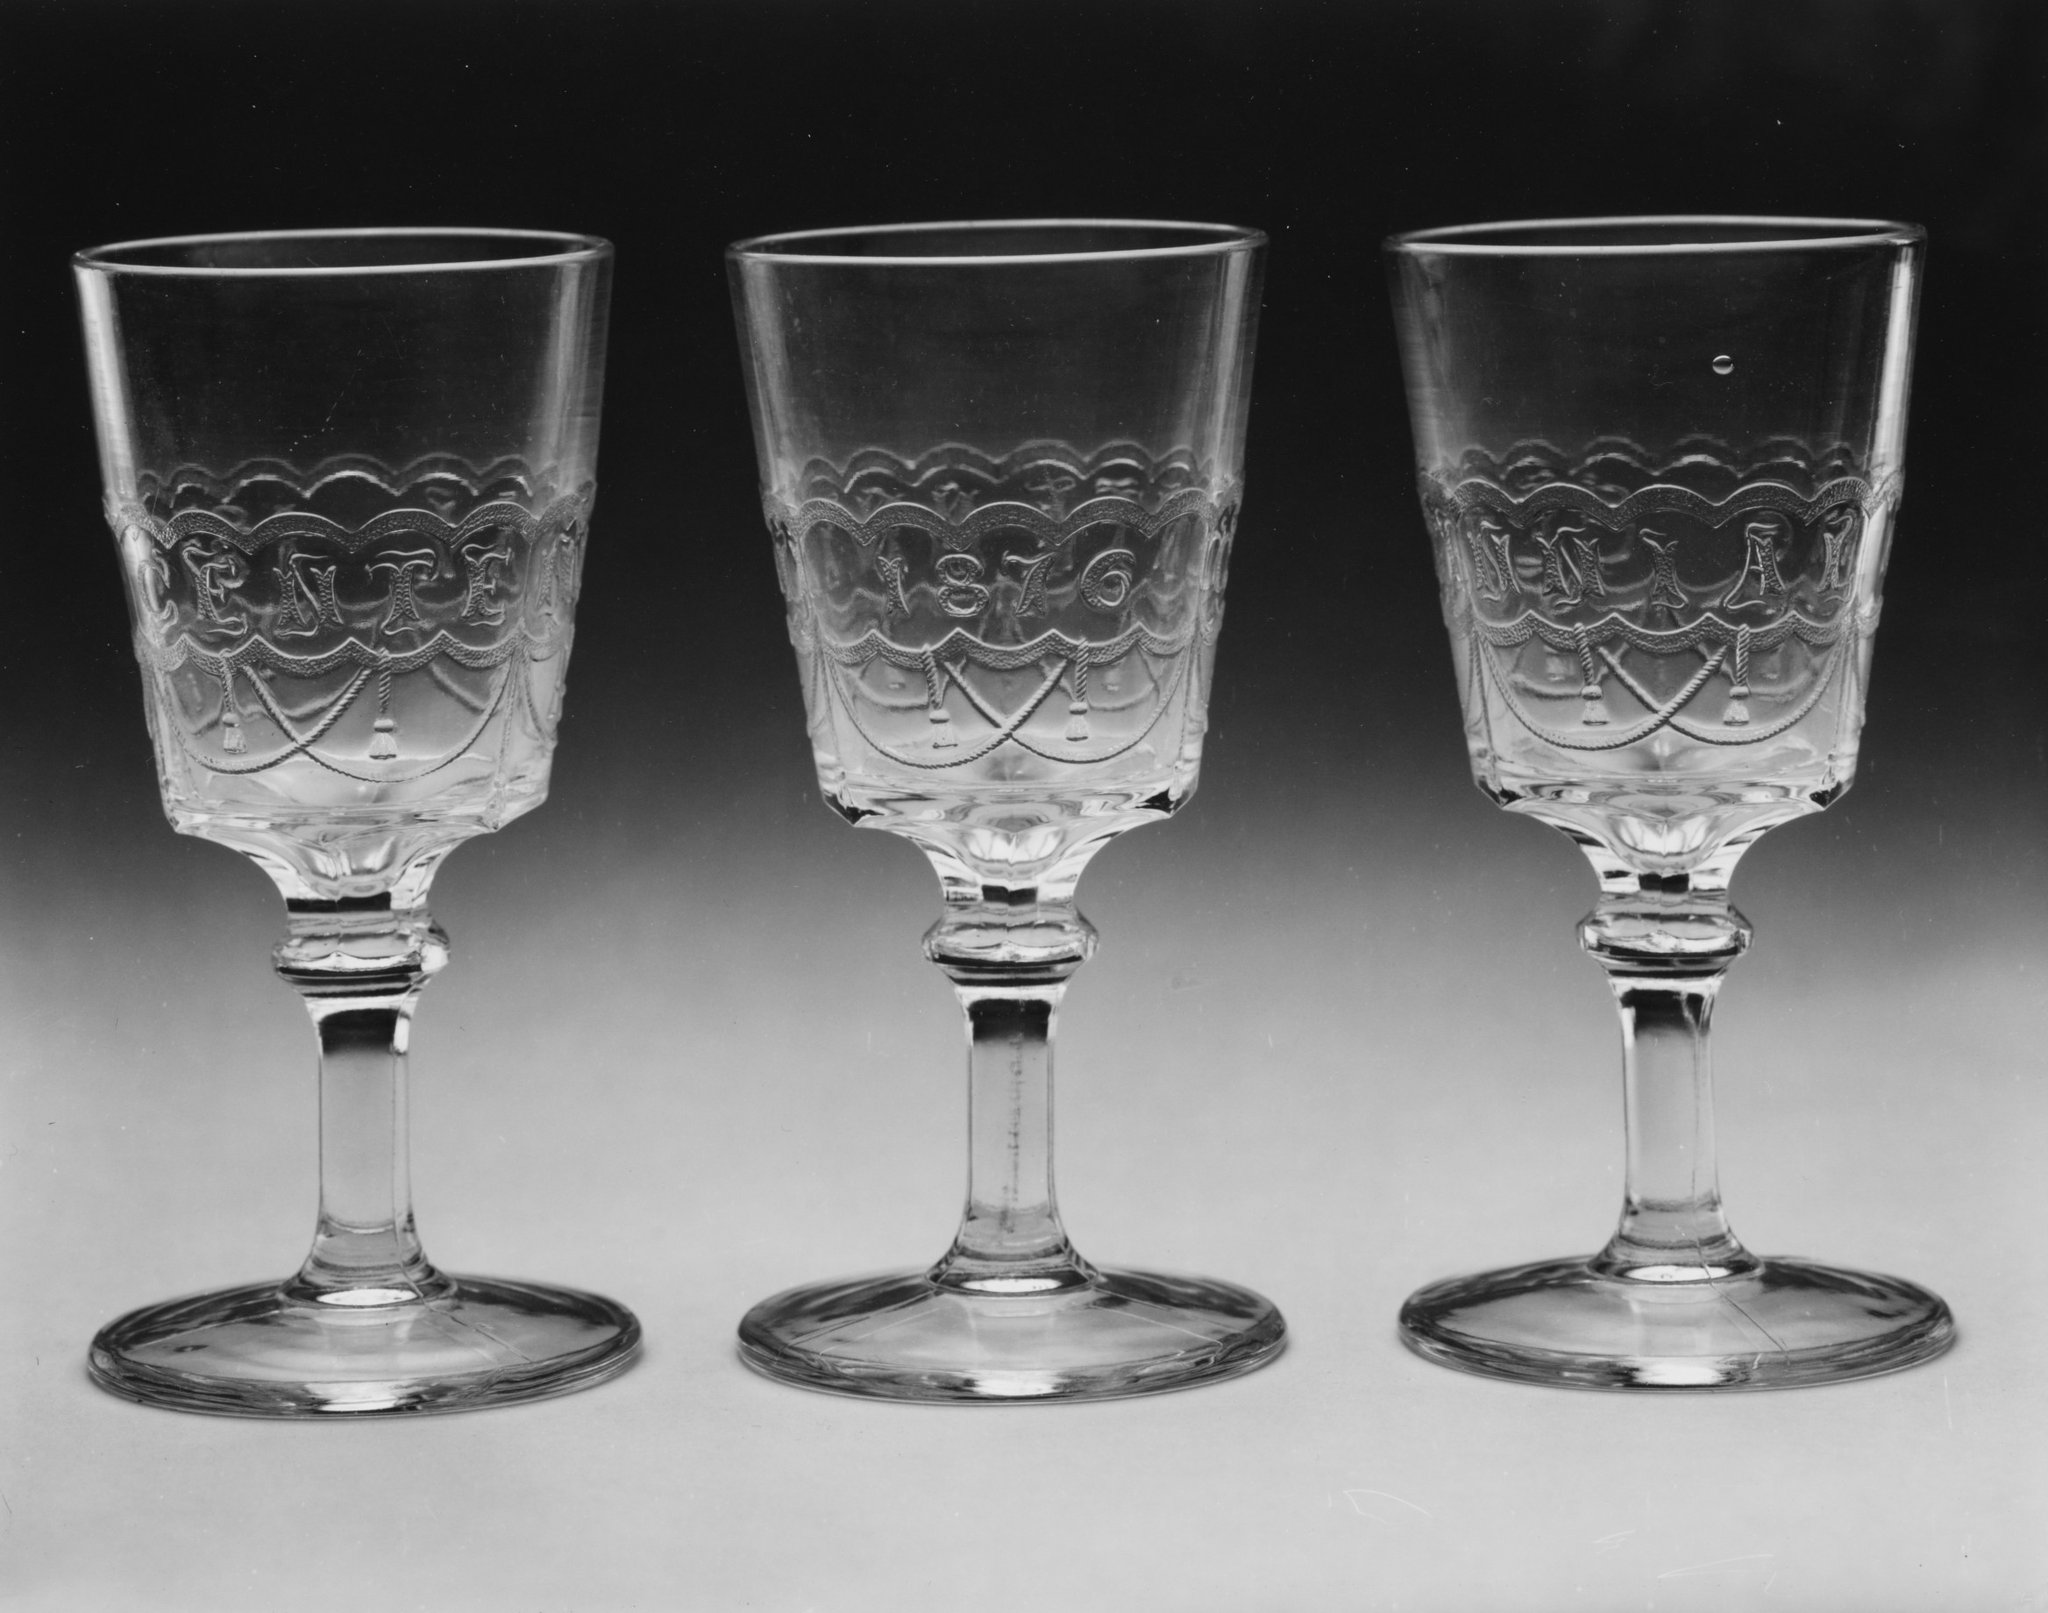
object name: goblet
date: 1876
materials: glass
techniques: glassblowing, molding